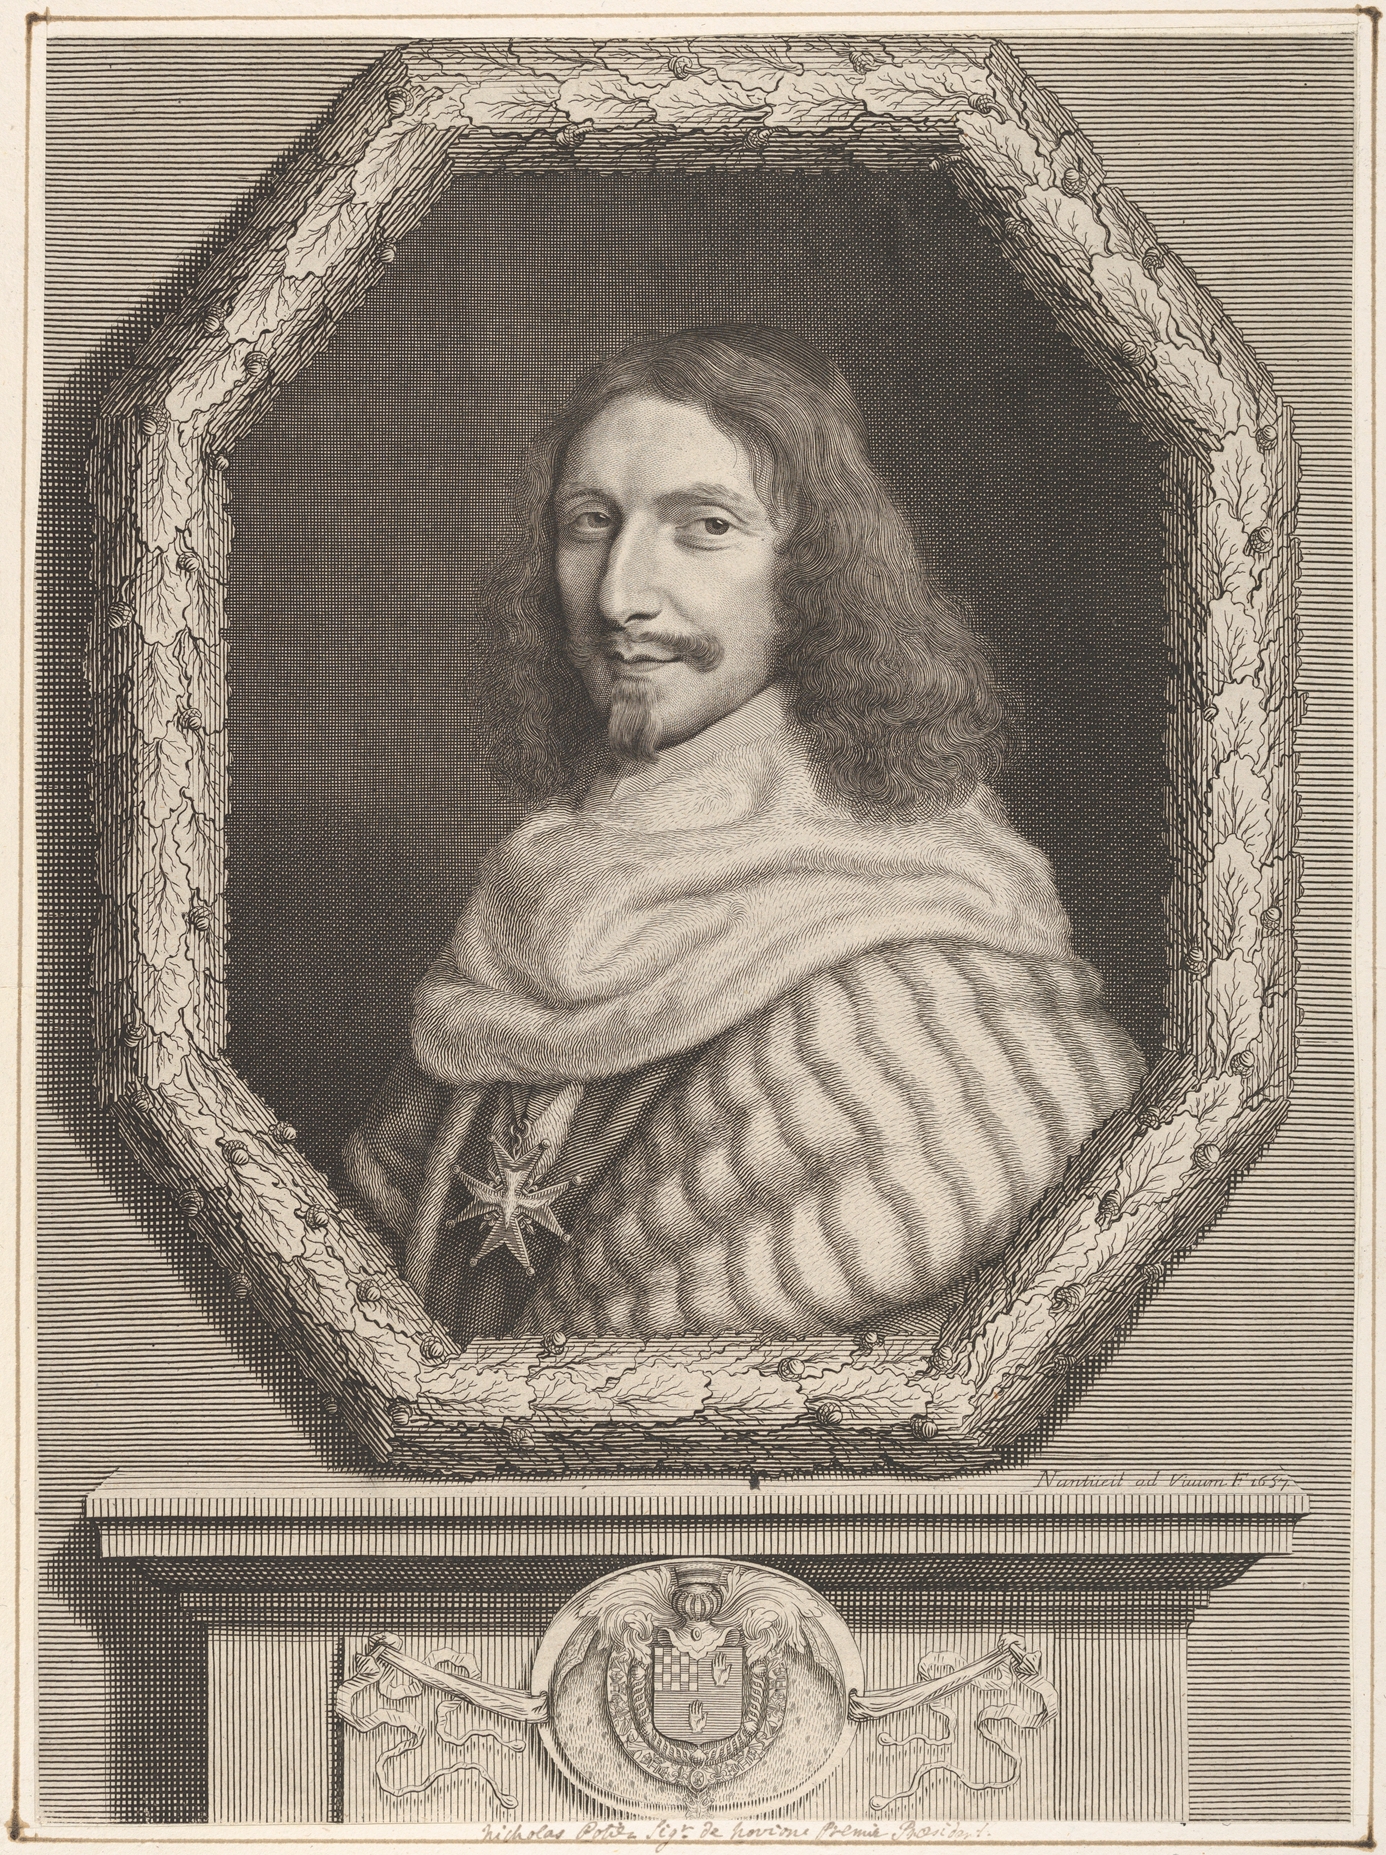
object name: print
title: Nicolas Potier de Novion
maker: robert nanteuil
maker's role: artist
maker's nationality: french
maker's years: 1623-1678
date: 1657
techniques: engraving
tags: men,portraits,coat of arms